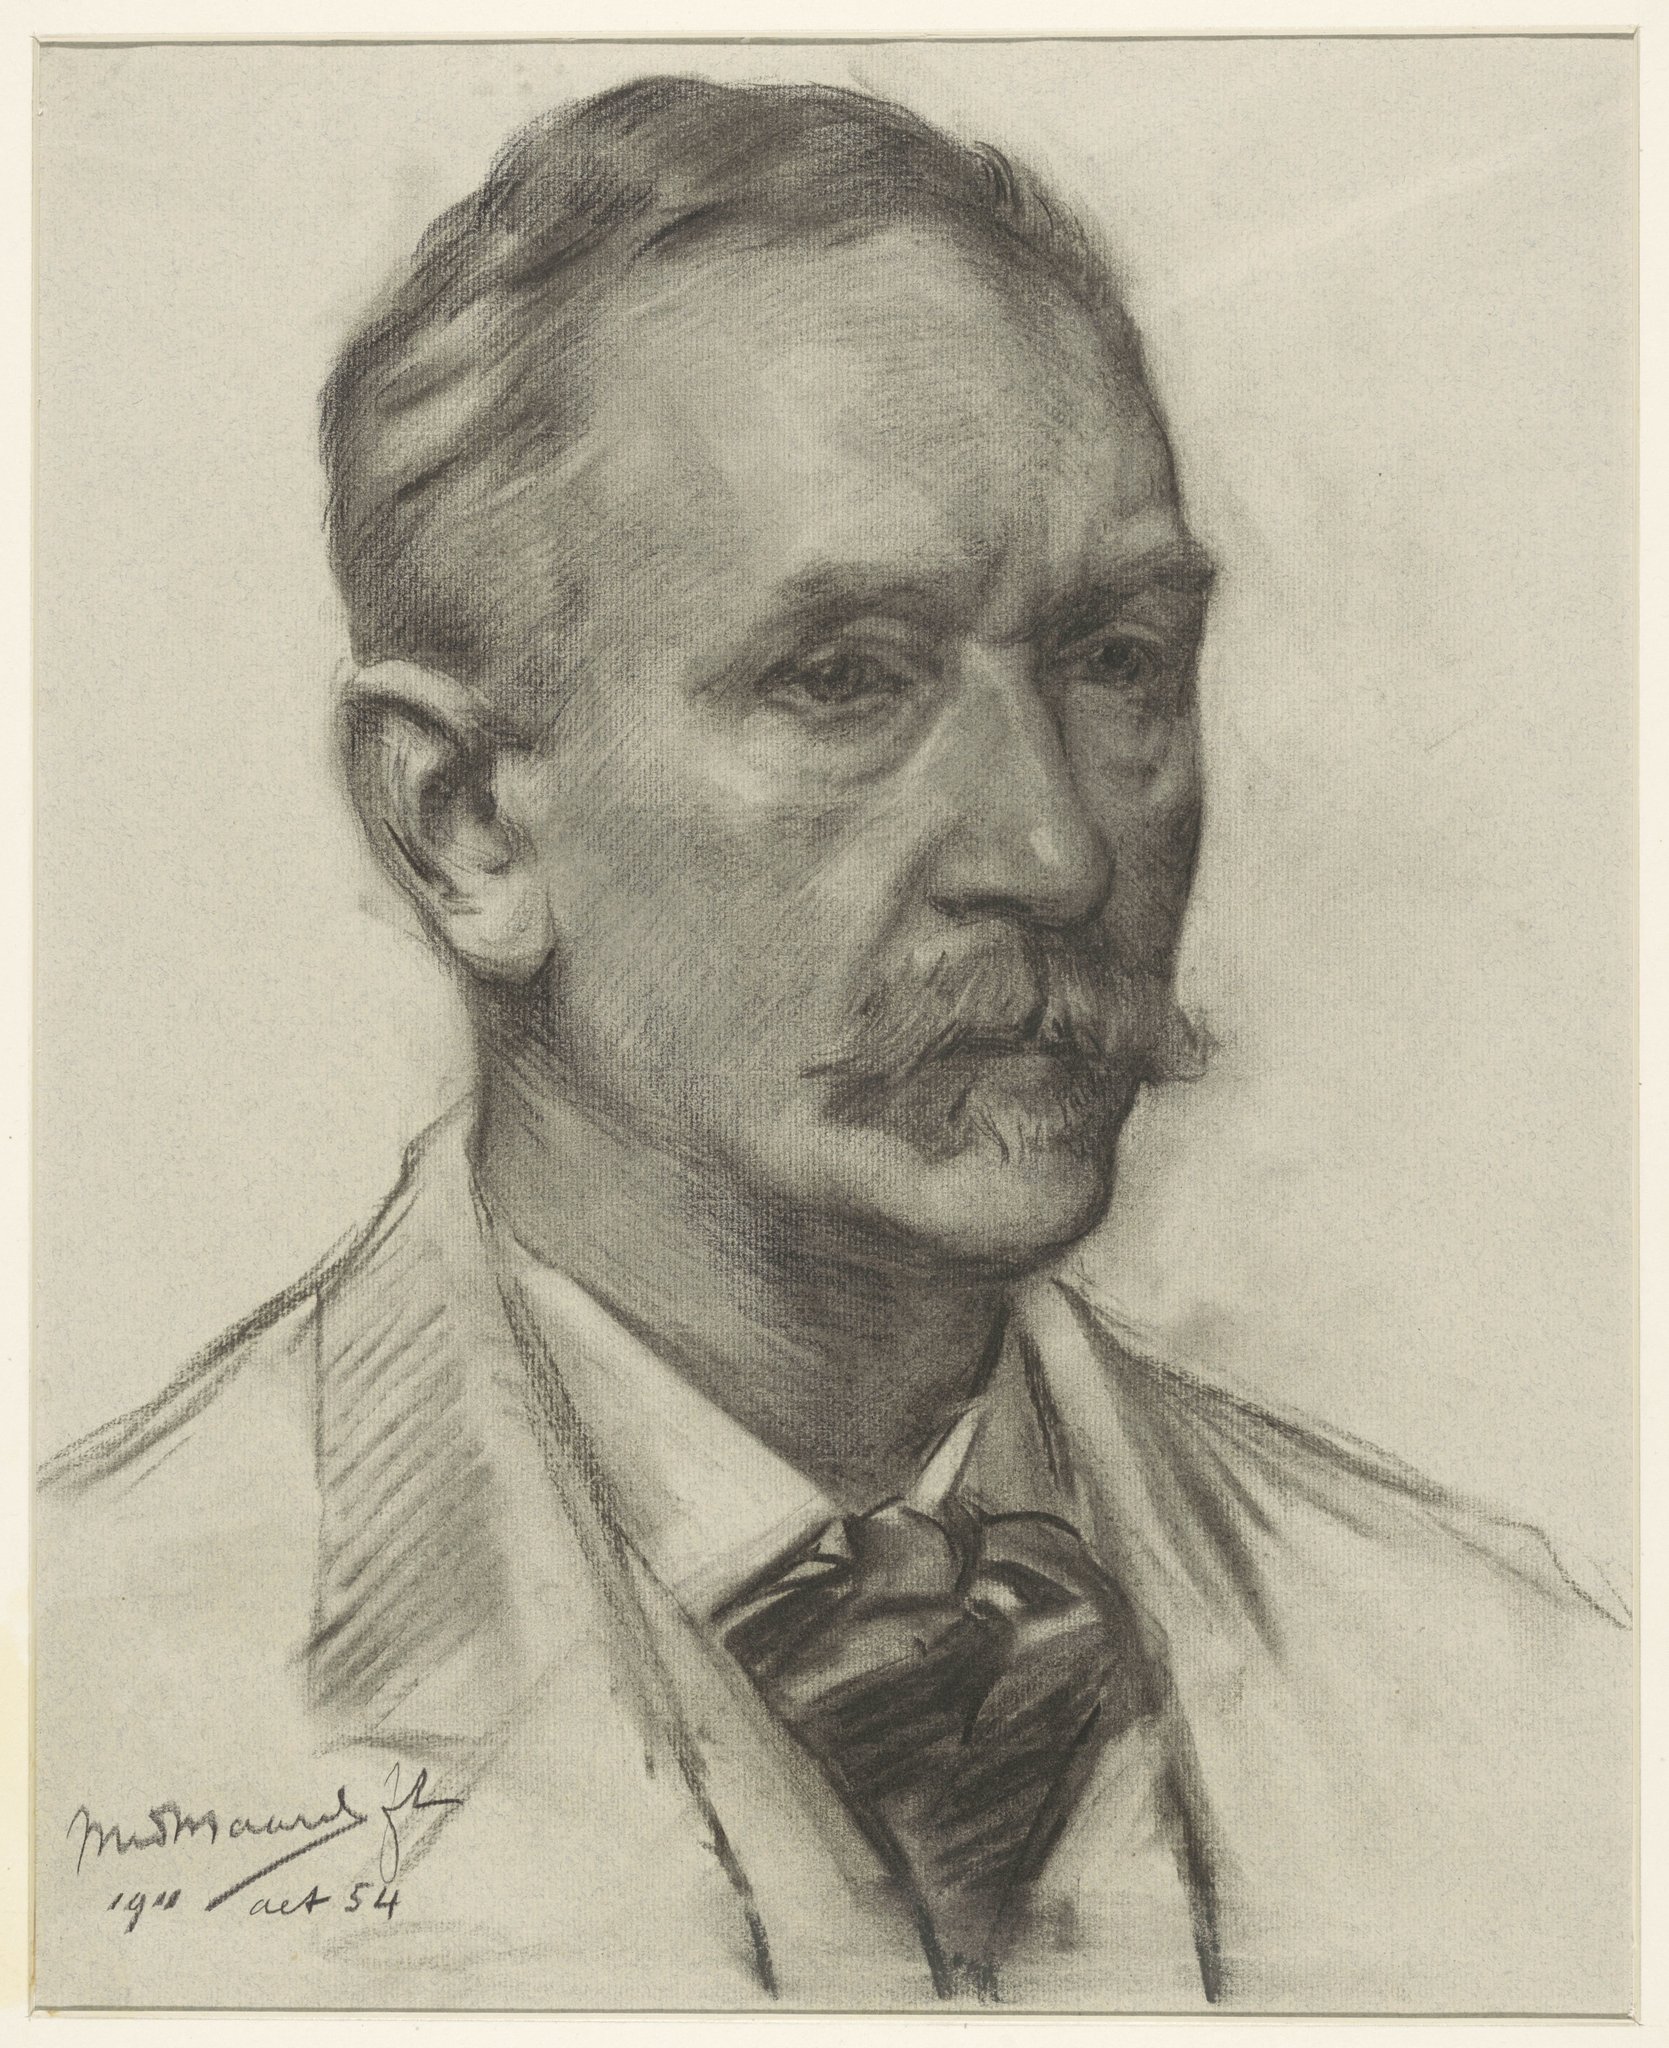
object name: drawing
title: Zelfportret van de schilder Marinus van der Maarel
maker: marinus van der maarel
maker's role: draughtsman, painter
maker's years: 1857-1921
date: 1911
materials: charcoal, paper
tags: the hague, painter, draughtsman, marinus van der maarel, historical persons, portrait, self-portrait of painter, portrait, self-portrait of artist